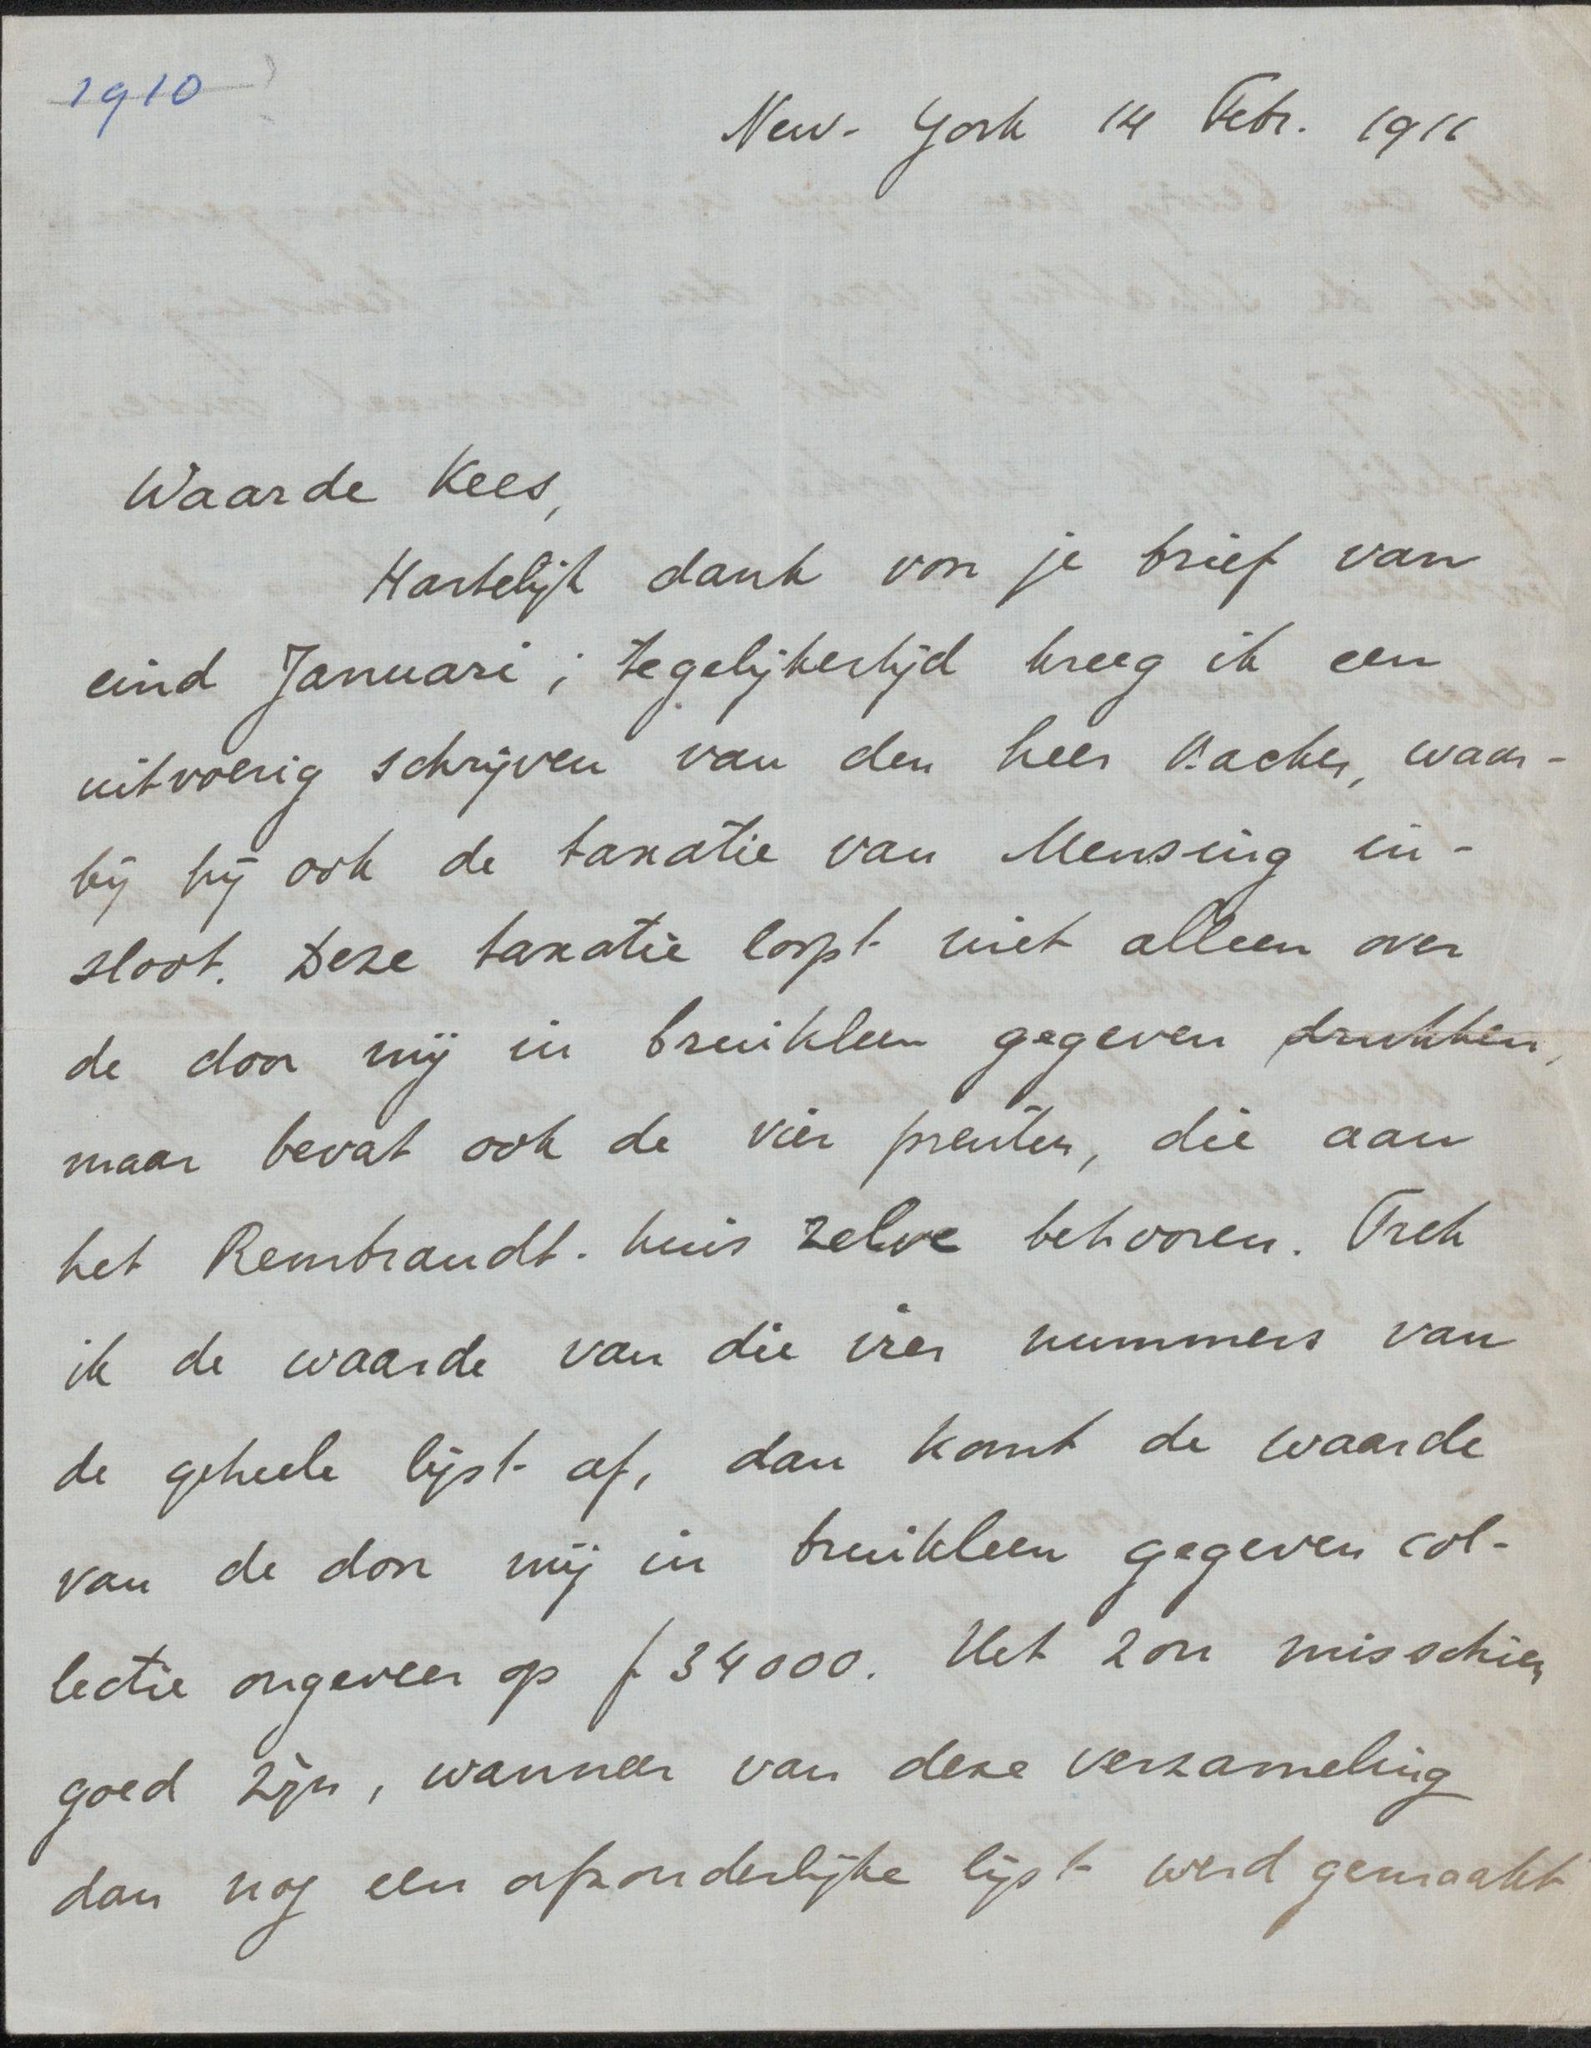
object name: letter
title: Brief aan Cornelis Gerardus 't Hooft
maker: jan veth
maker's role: designer, draughtsman, painter, print maker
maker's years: 1864-1925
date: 1911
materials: ink, paper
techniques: pen, writing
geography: new york city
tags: amsterdam, antonius wilhelmus mari mensing, painter, print maker, draughtsman, albrecht dürer, cornelis gerardus 't hooft, drawing, the graphic arts, art collecting, money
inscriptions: collector's mark: ‘RPK’